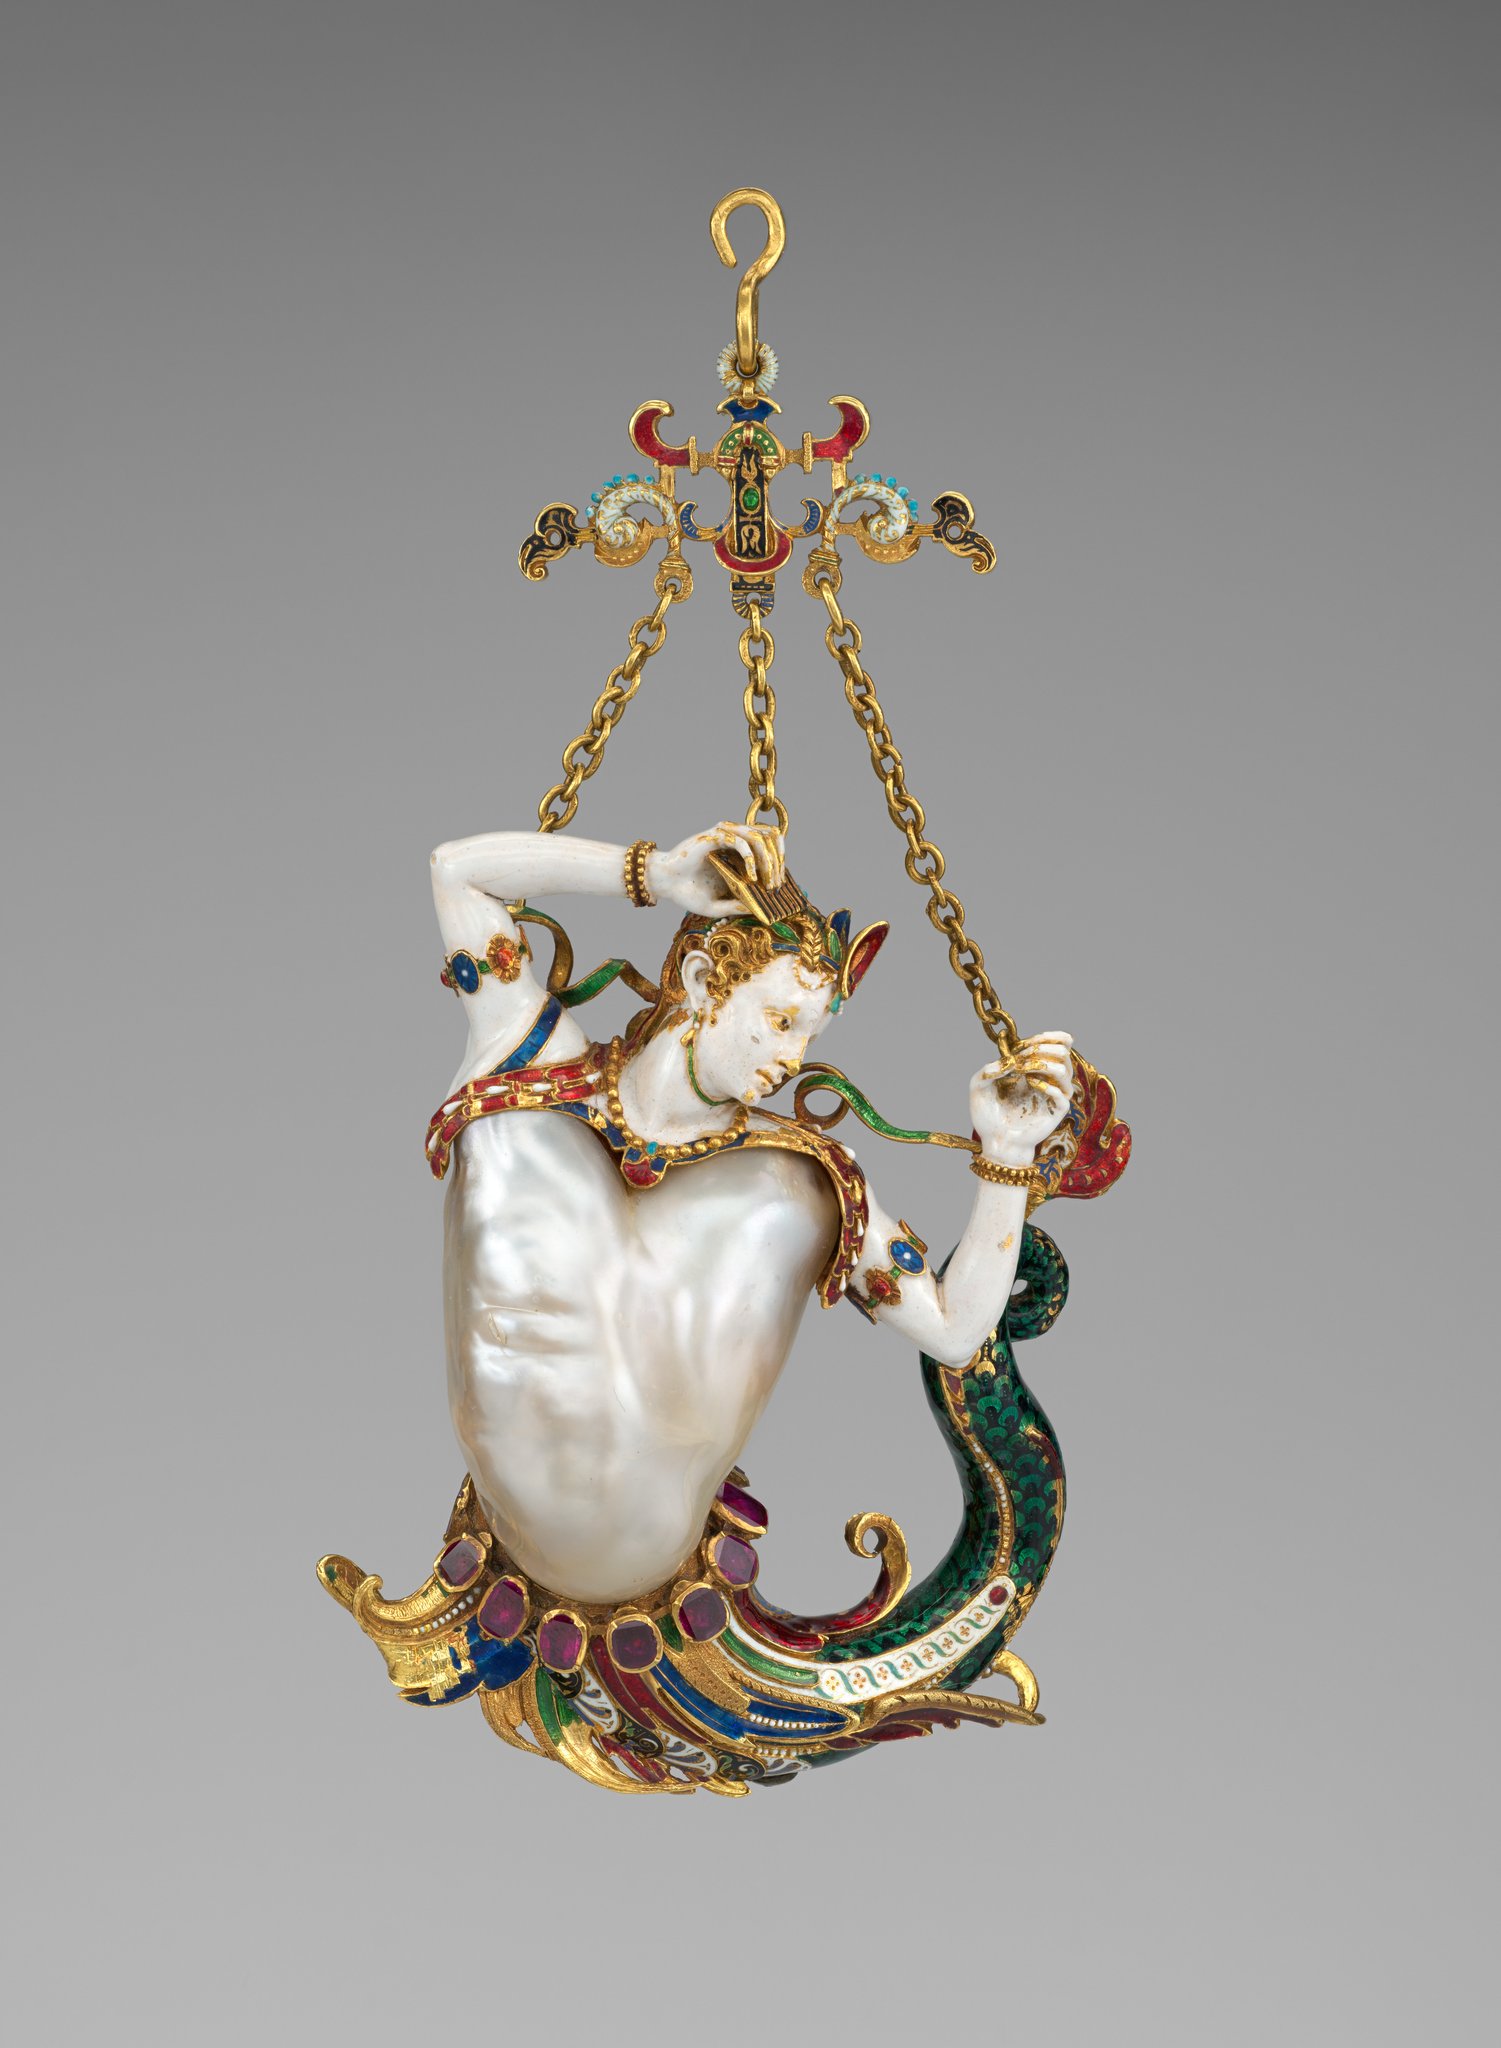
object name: pendant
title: Pendant in the form of a siren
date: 1860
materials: gold, pearl, gemstone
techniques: enamel